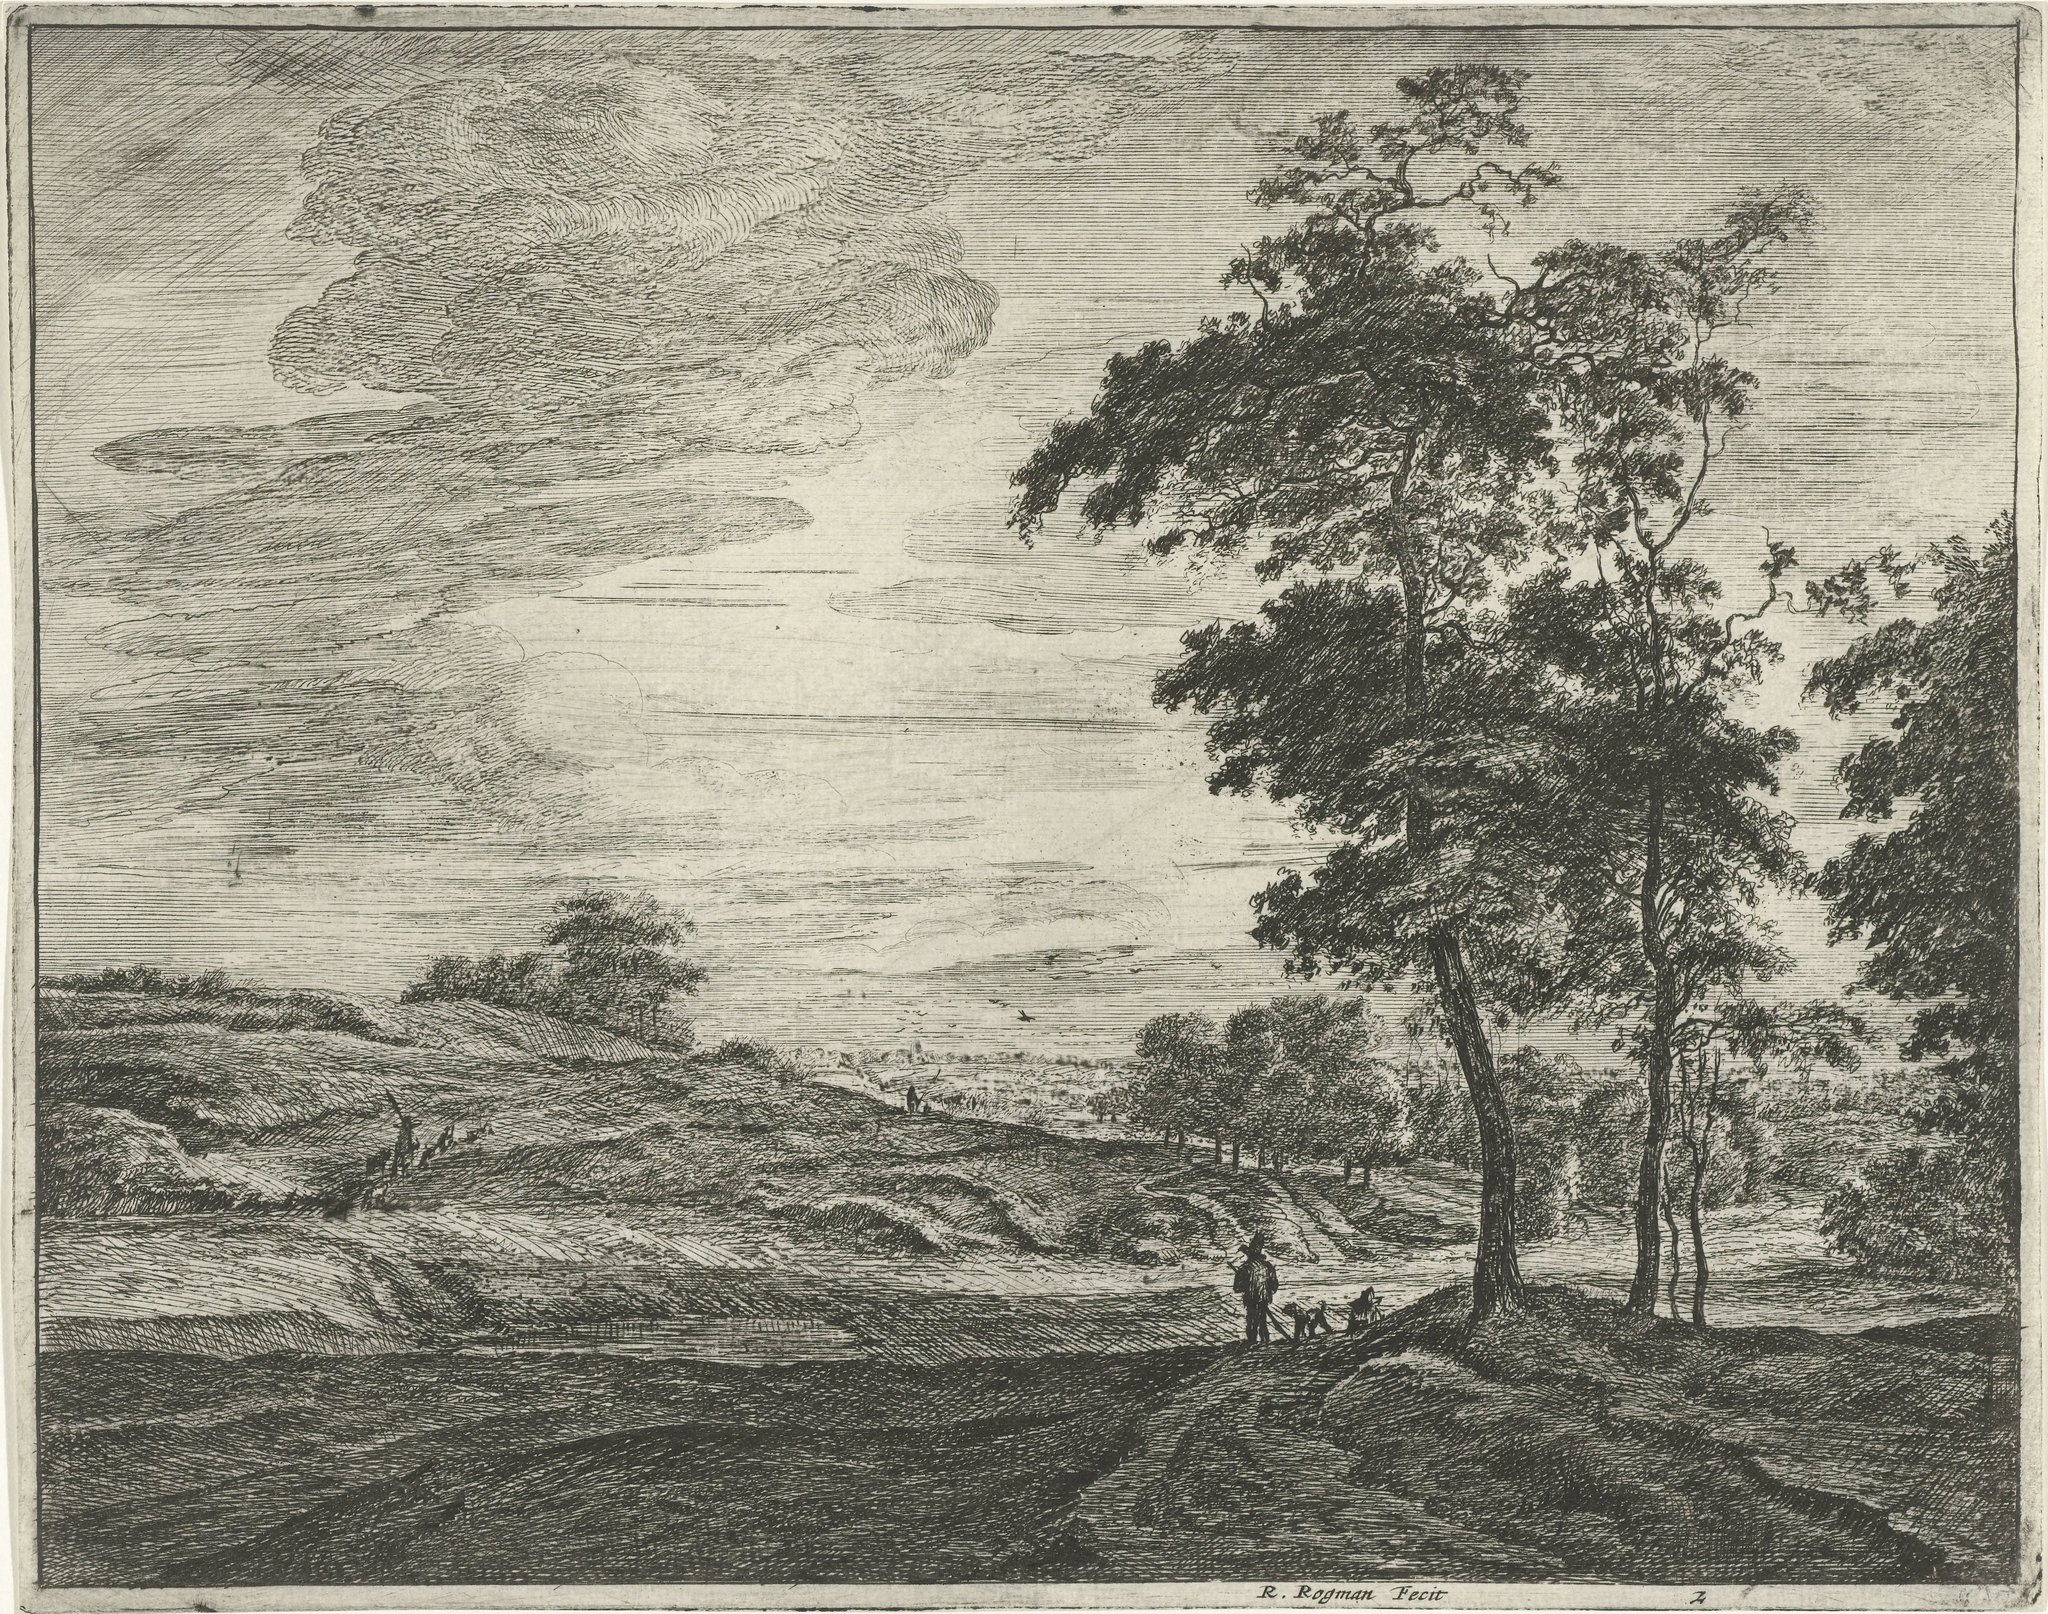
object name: print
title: Aan de rand van het Haagse Bos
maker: roelant roghman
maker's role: draughtsman, painter, print maker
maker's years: 1627-1692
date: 1637-1692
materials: paper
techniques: etching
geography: amsterdam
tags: low hill country, forest, wood, dog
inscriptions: collector's mark: Lugt 2228a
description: Gezicht op een glooiend landschap aan de rand van het Haagse Bos. Op de voorgrond twee mannen en een hond.